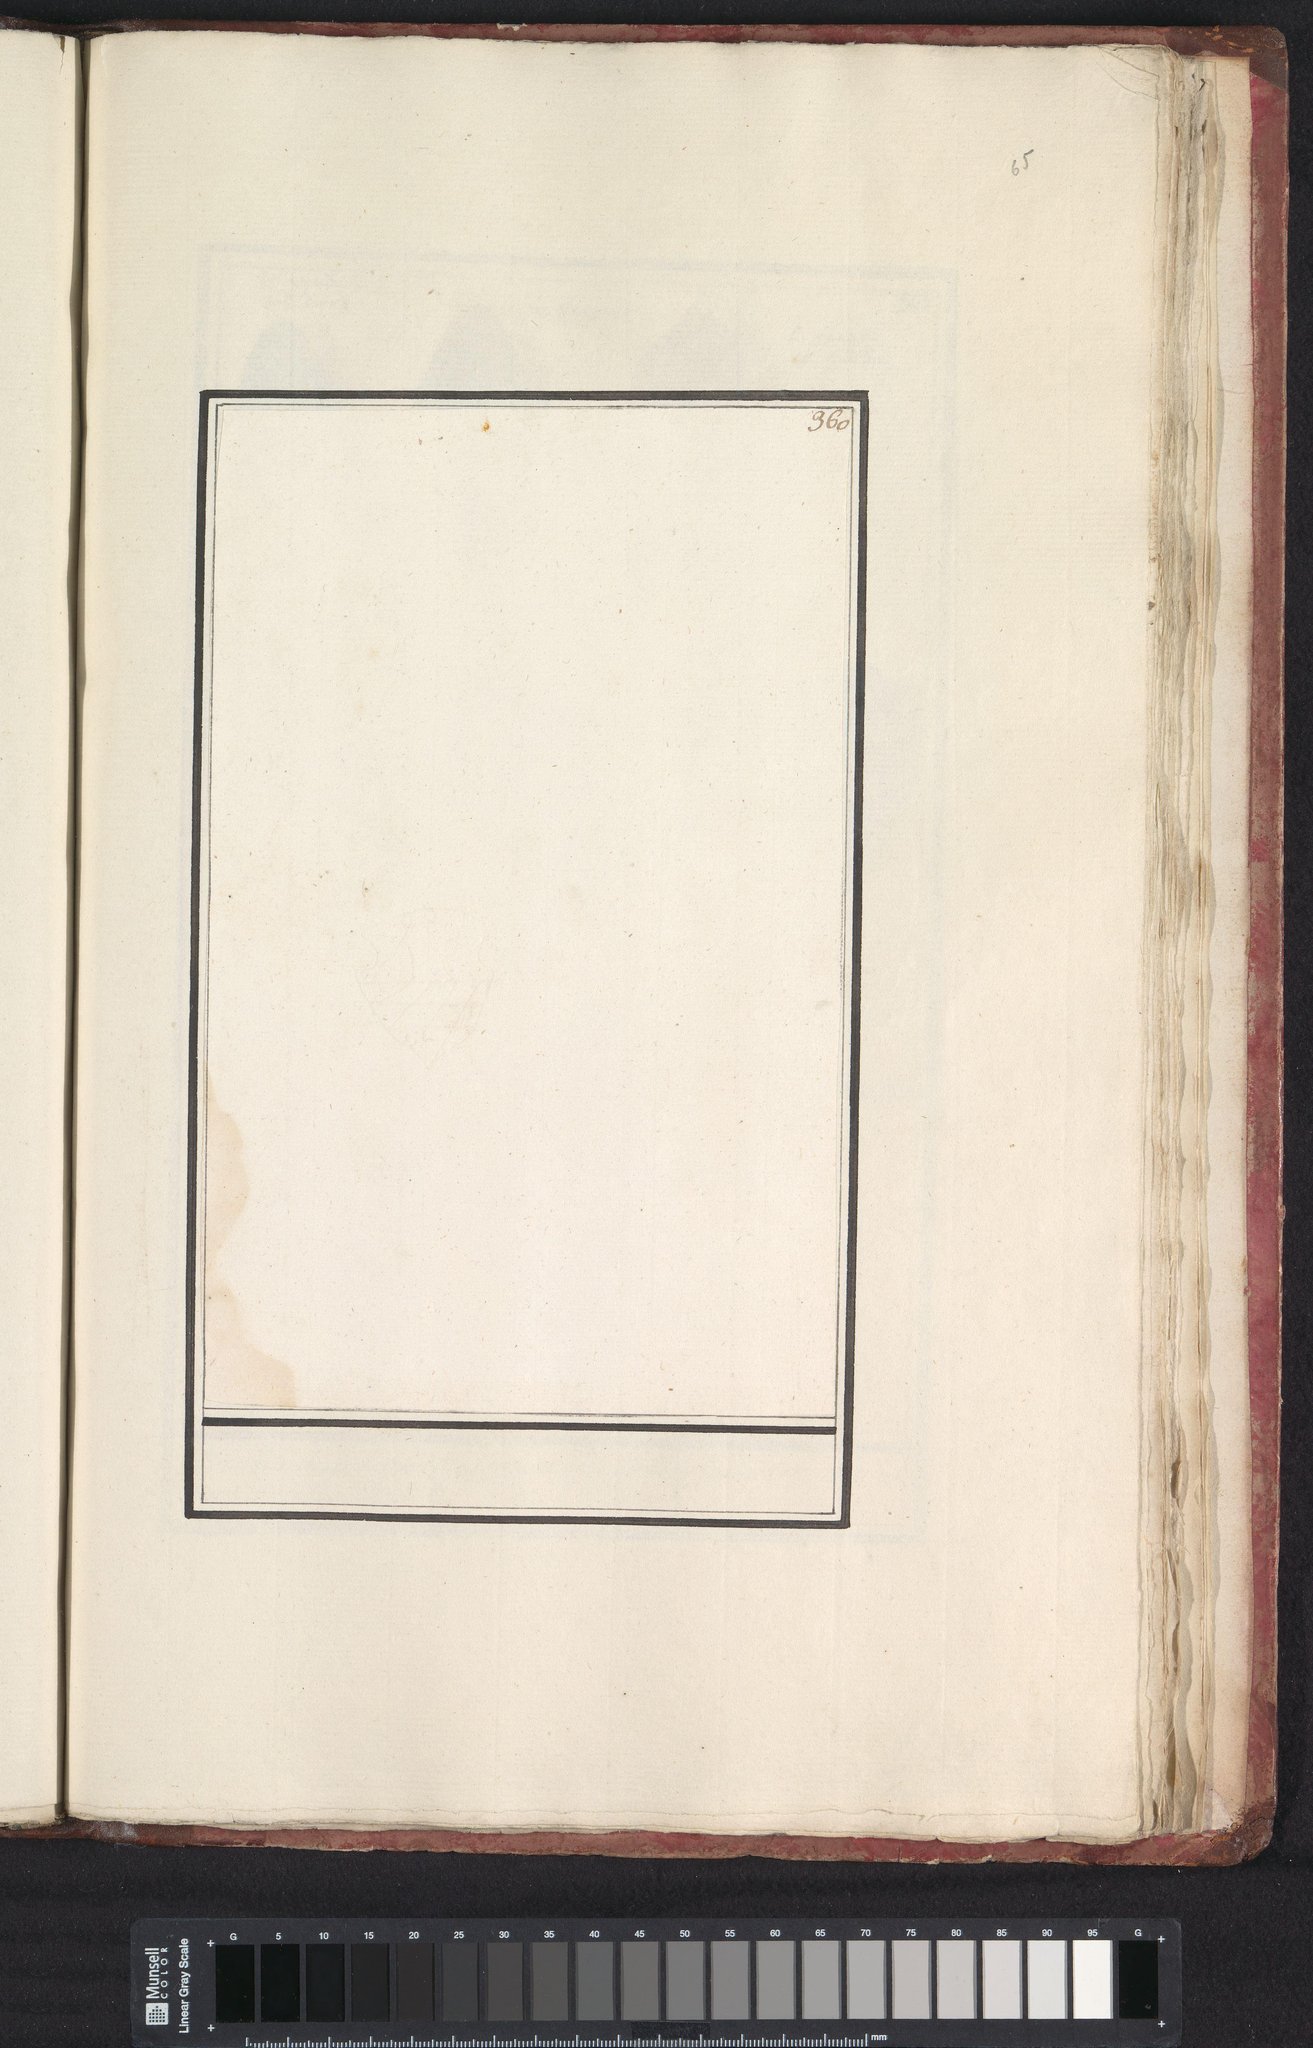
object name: drawing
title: Omlijsting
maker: Anonymous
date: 1809-1814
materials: paper, pencil, watercolor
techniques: brush, pen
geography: southern netherlands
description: Lege omlijsting. Rechtsboven genummerd: 360. Onderdeel van het vierde album met tekeningen van bloemen en paddestoelen. Elfde van twaalf albums met tekeningen van dieren, vogels en planten bekend rond 1600, gemaakt in opdracht van keizer Rudolf II. Met toelichting in Nederlands, Latijn en Frans.